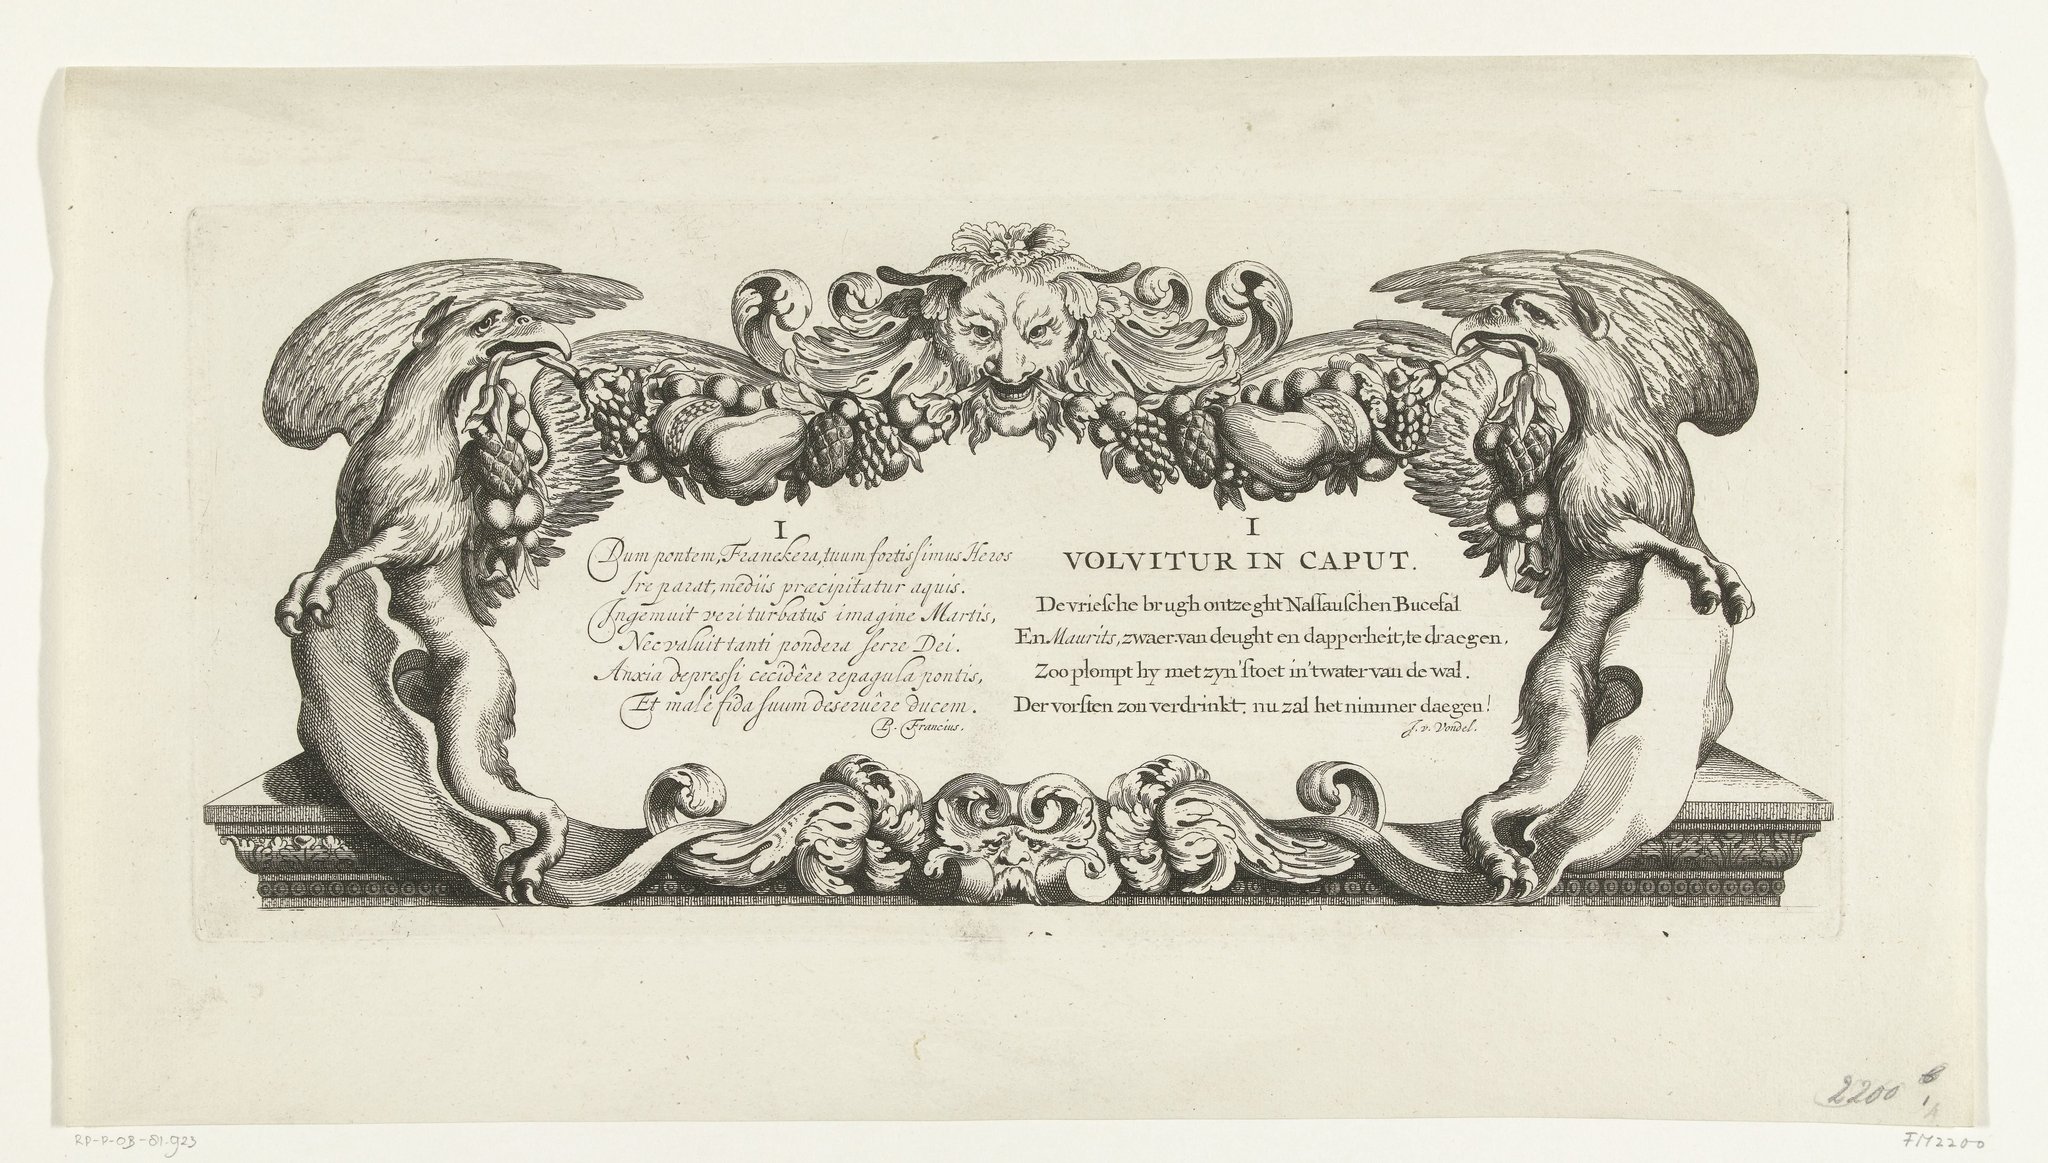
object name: print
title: Teksten bij de voorstelling van het ongeluk van graaf Johan Maurits op de brug van Franeker, 1665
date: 1665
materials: paper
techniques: etching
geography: northern netherlands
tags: earl, johan maurits graaf van nassau-siegen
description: Blad met een cartouche met twee teksten behorend bij de eerste plaat met de voorstelling van het ongeluk van graaf Johan Maurits op de brug van Franeker, 6 januari 1665. Cartouche gevormd door een festoen van vruchten vastgehouden door twee griffioenen. Links een vers van zes regels in het Latijn, rechts een vers van 4 regels in het Nederlands.